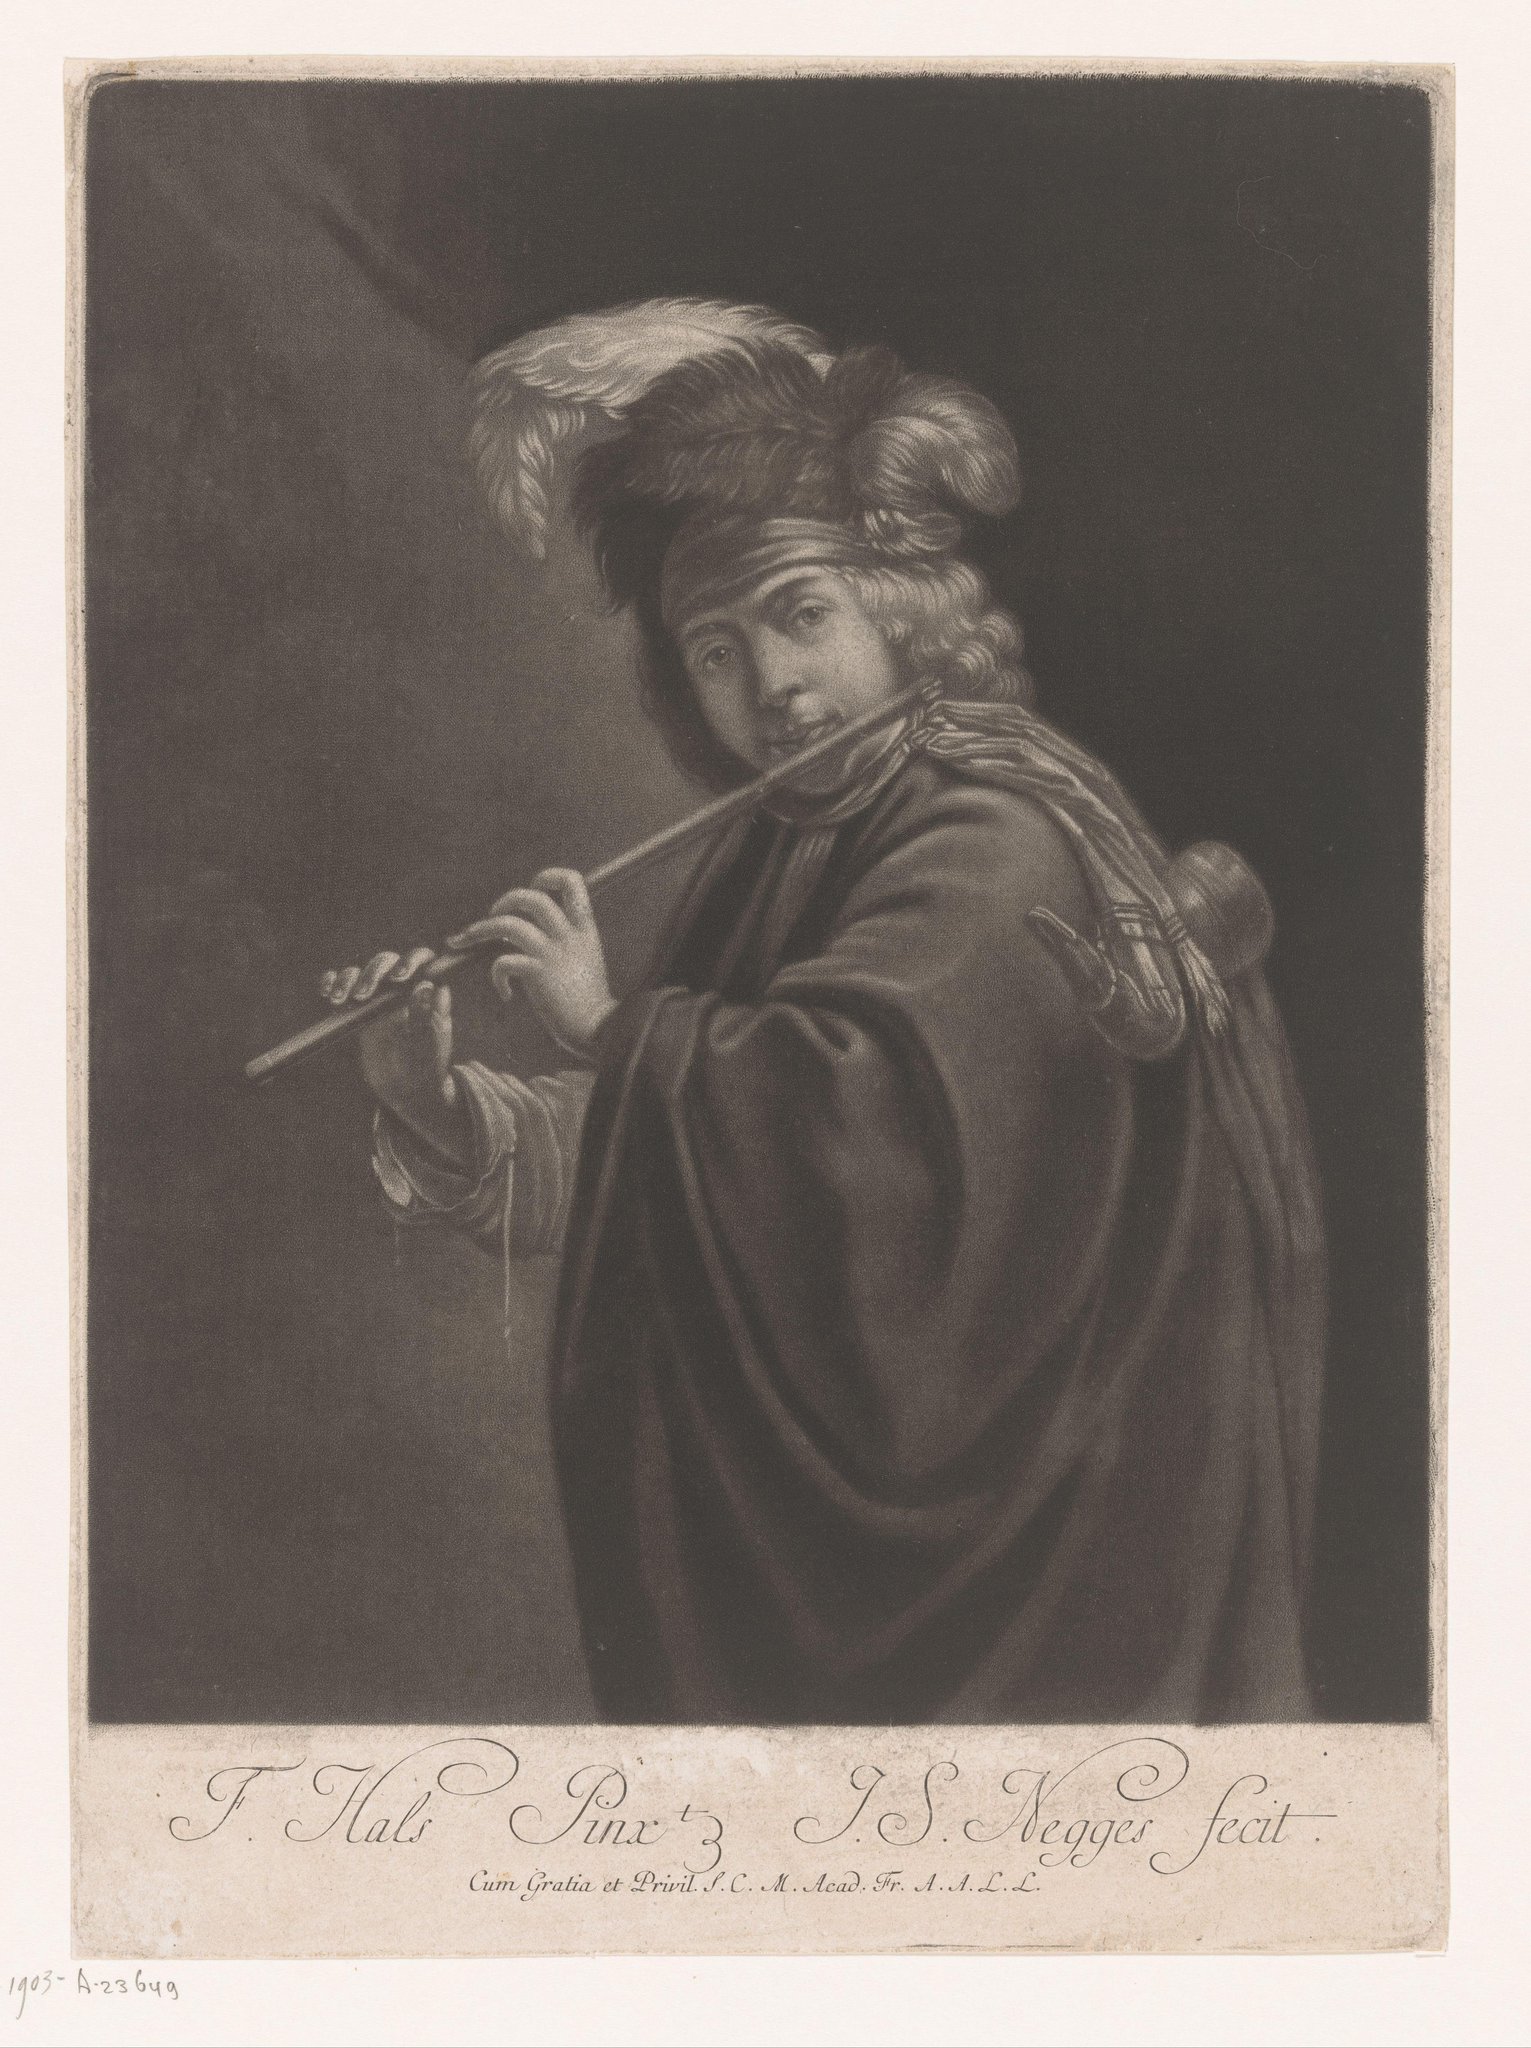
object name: print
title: Dwarsfluit spelende jongeman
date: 1736-1792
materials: paper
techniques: mezzotint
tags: flute, aulos, tibia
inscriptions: collector's mark: Lugt 2228